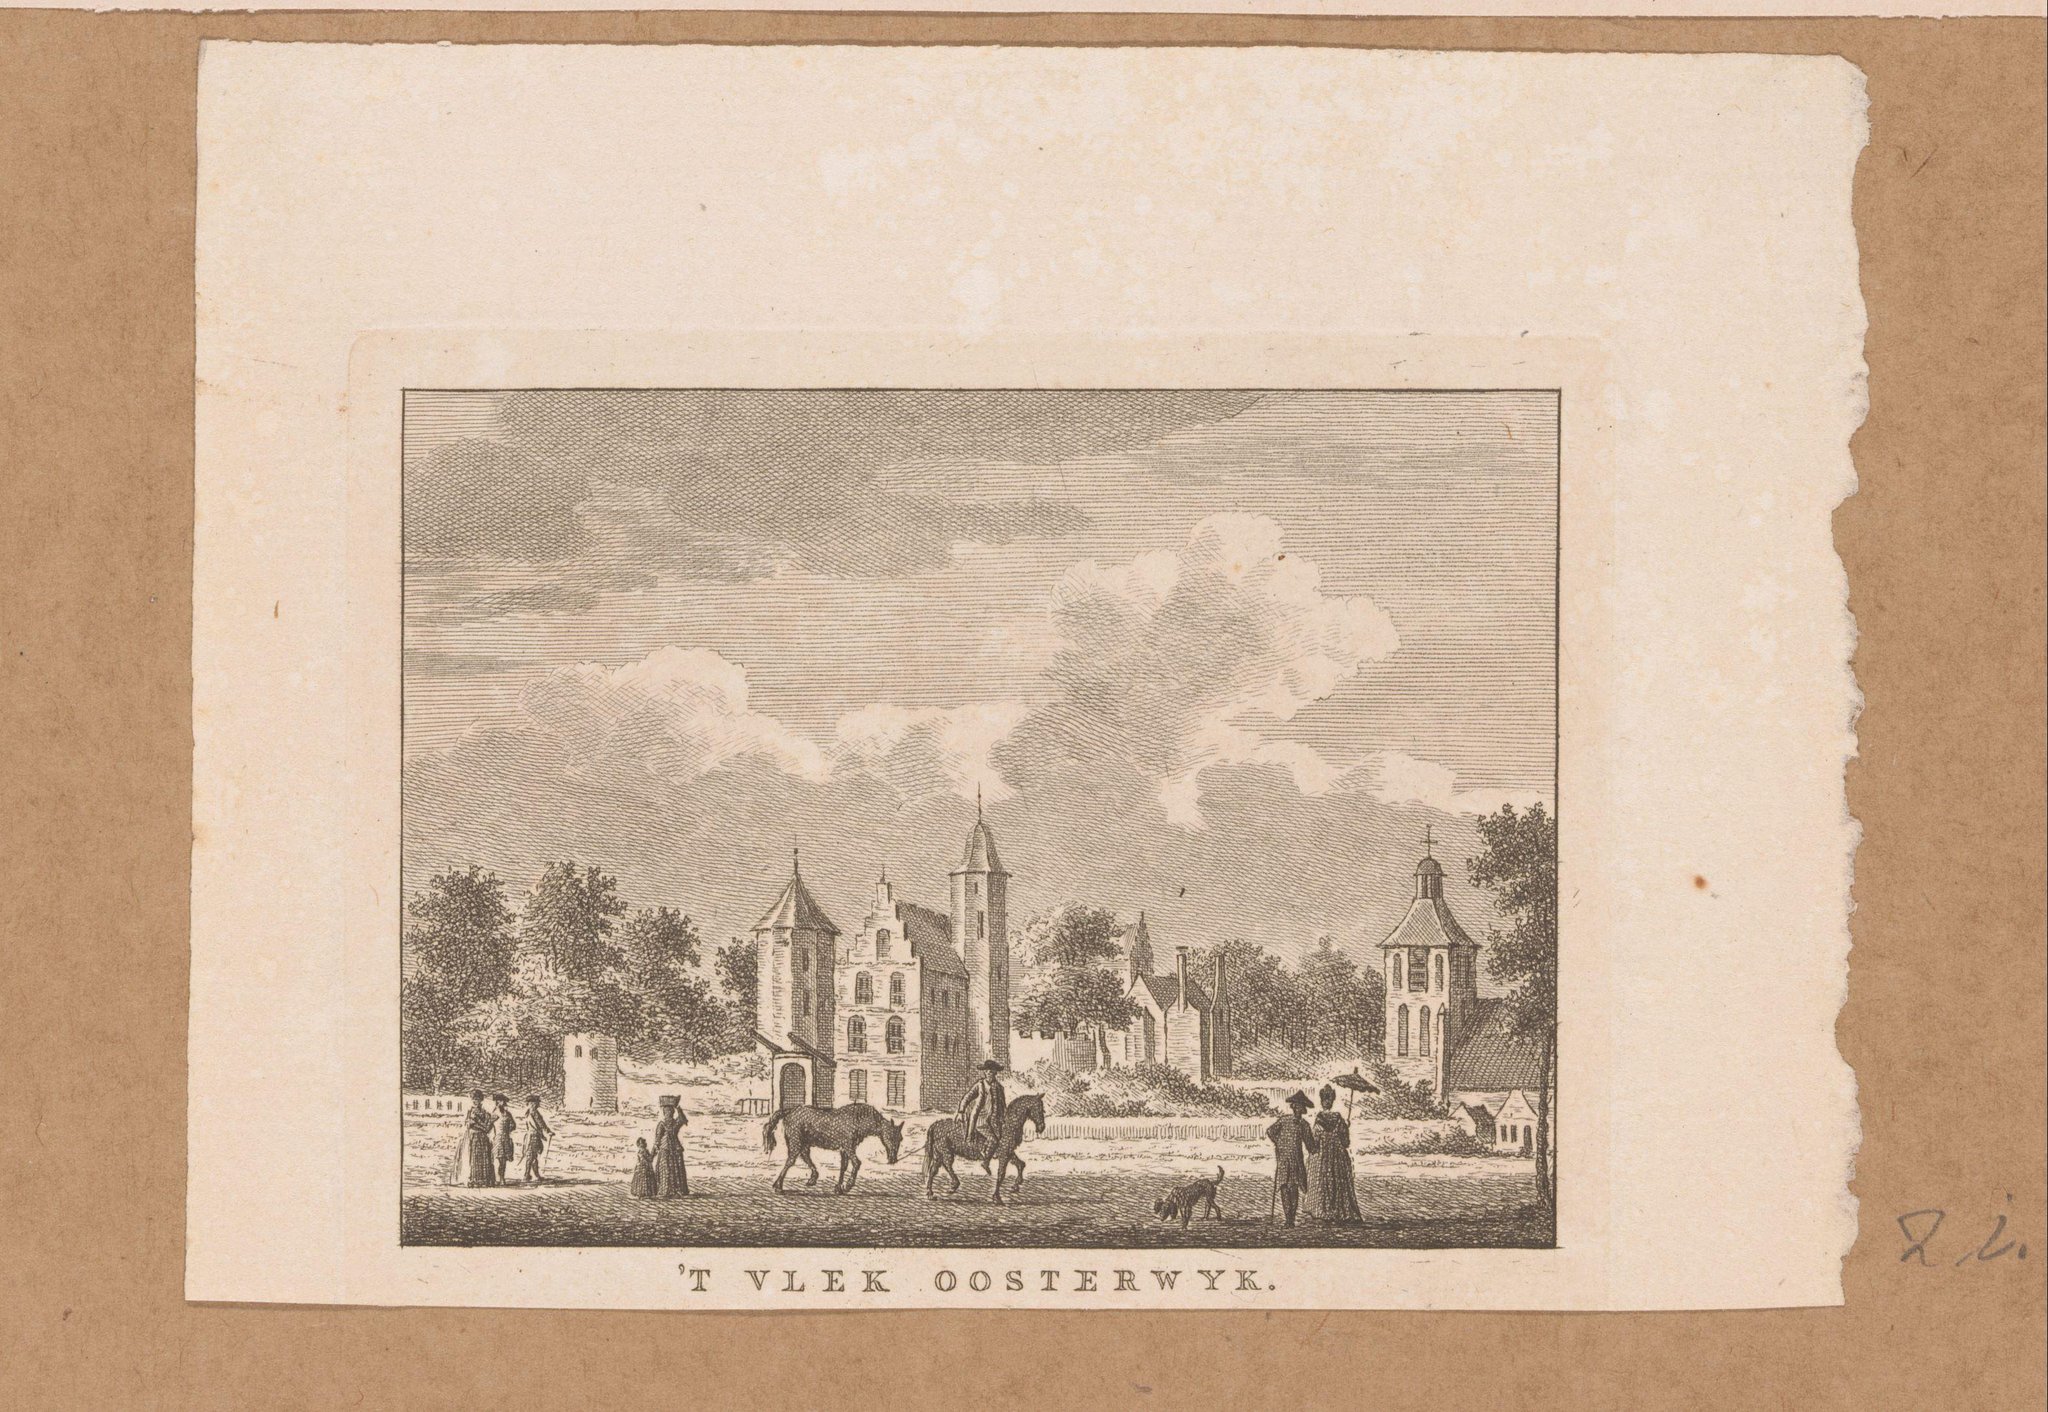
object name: book illustration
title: 't Vlek Oosterwyk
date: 1786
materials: paper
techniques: engraving, etching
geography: amsterdam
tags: castle, village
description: Prent uit: Bulthuis, Jan. Vaderlandsche gezichten of afbeeldingen (...). 3 dln. Amsterdam: Hendrik Gartman, 1786, dl. 3.